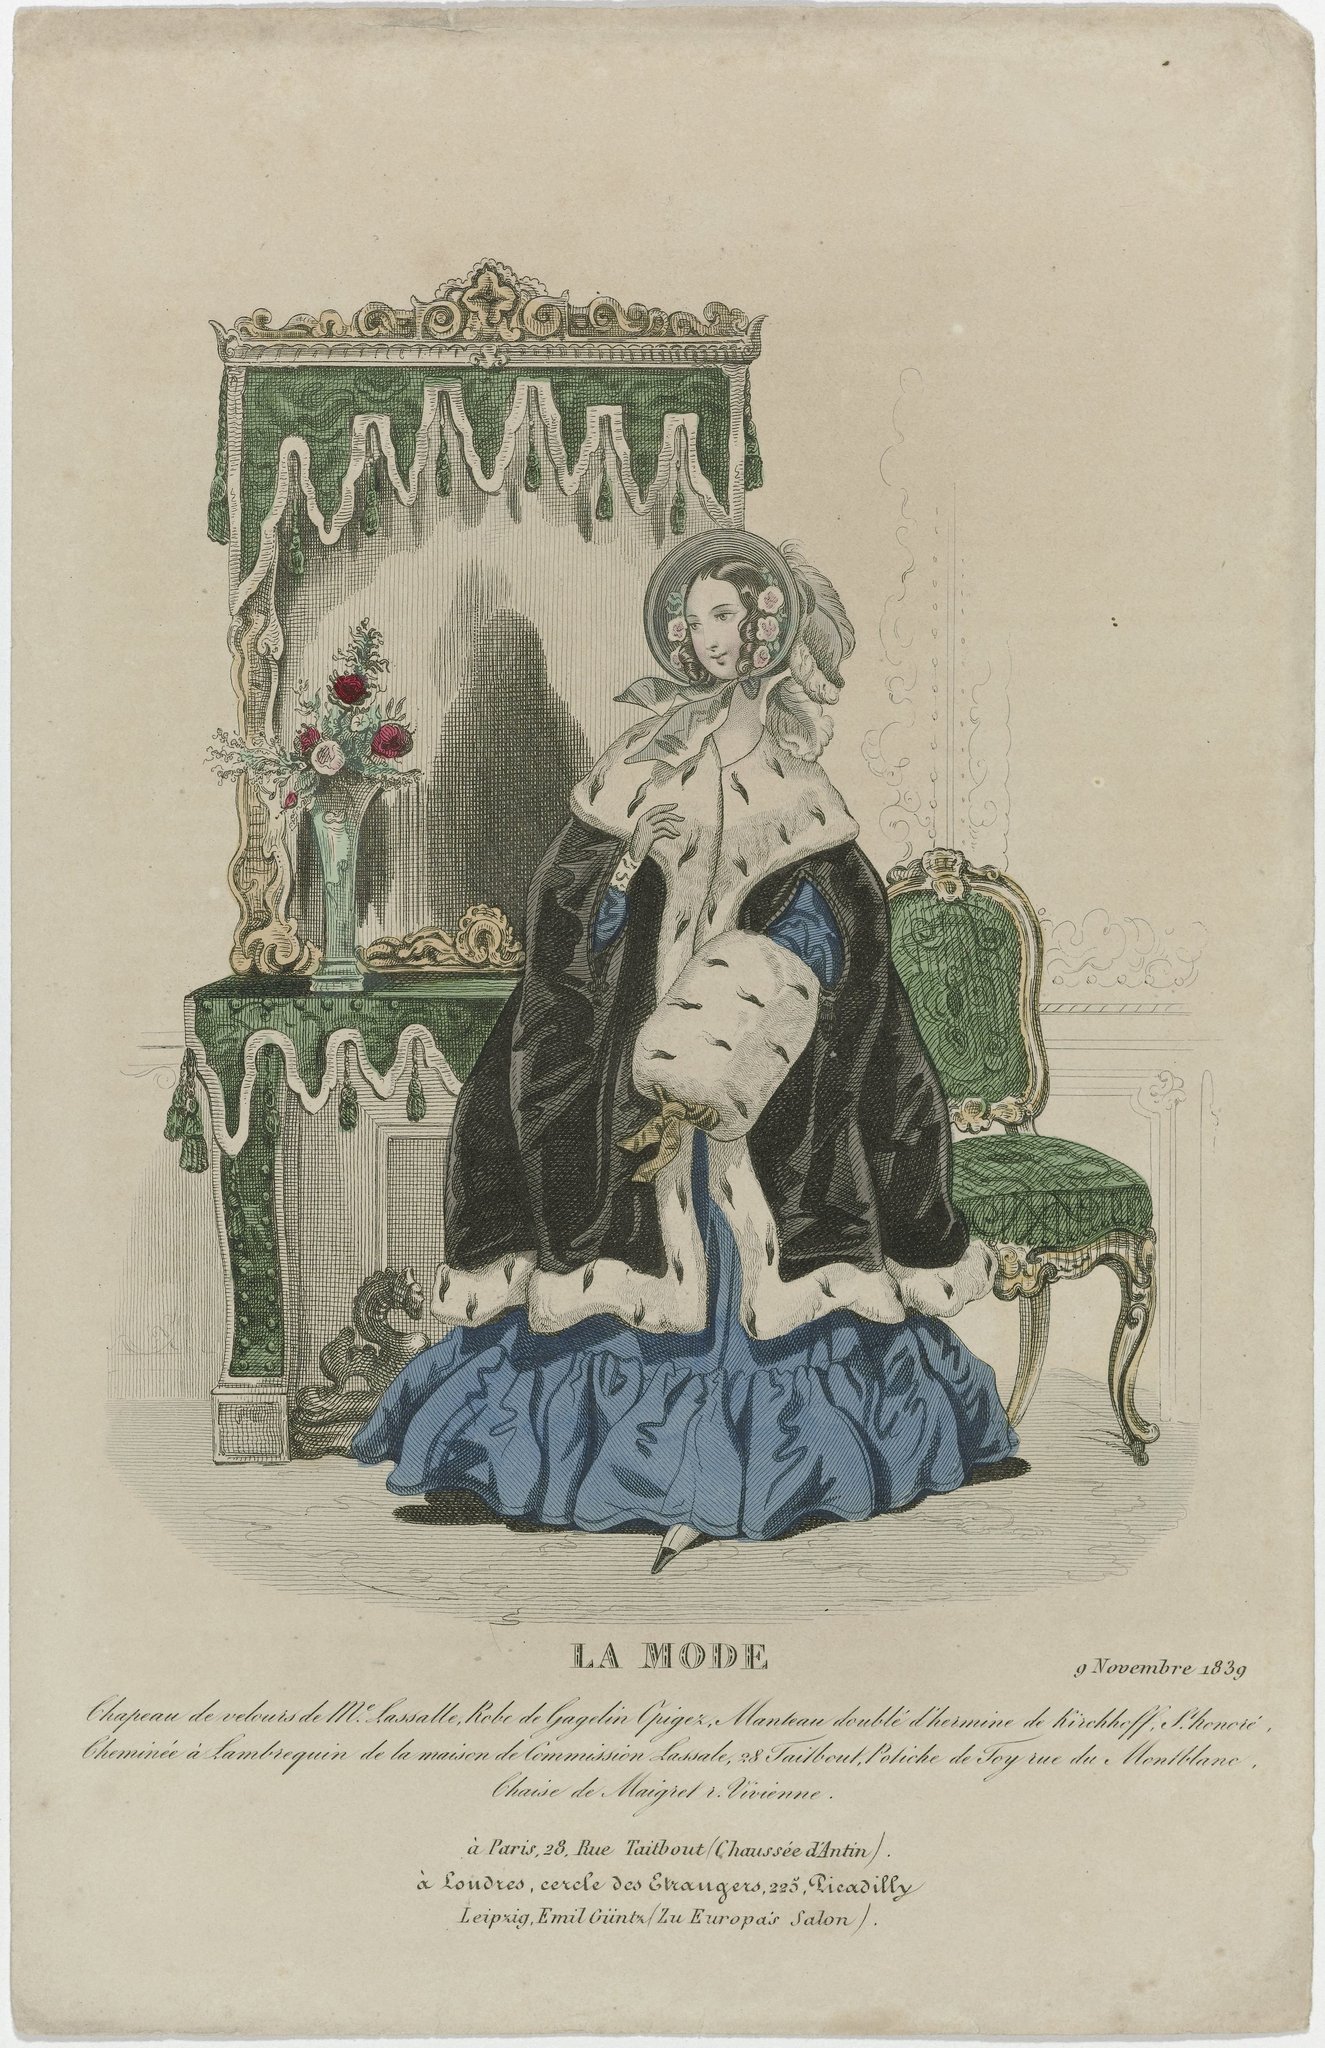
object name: fashion print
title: La Mode, 9 novembre 1839 : Chapeau de velours de Me Lassall (...)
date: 1839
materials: paper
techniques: engraving, hand coloring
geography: paris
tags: canopy, baldachin, coat (+ fur used for clothes), coat (+ women's clothes), open hearth, fire-place, fashion plates, head-gear: hat (+ women's clothes), dress, gown (+ women's clothes), flowers in a vase, muff (+ fur used for clothes), chair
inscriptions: title: ‘La Mode’, address: ‘à Paris, 28, Rue Taitbout ( Chaussée d'Antin ). / à Londres, cercle des Etrangers, 225, Picadilly / Leipzig, Emil Güntz ( Zu Europa's Salon).’, caption: ‘Chapeau de velours de M.e Lassalle, Robe de Gagelin Opigez, manteau doublé d'hermine de Kirchhoff, St. honoré, Cheminée à Lambrequin de la maison de Commission lassale, 28 Tailbout, Potiche de Toy rue du montblanc, Chaise de Maigret r. Vivienne.’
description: Hoed van fluweel van Me Lassalle. Japon van Gagelin. Mantel gevoerd met hermelijn van Kirchhoff. Mof van hermelijn. Open haard met baldakijn 'de la maison de Commission Lassale'. Vaas met bloemen van Toy. Stoel van Maigret. Prent uit het modetijdschrift La Mode (1829-1855).